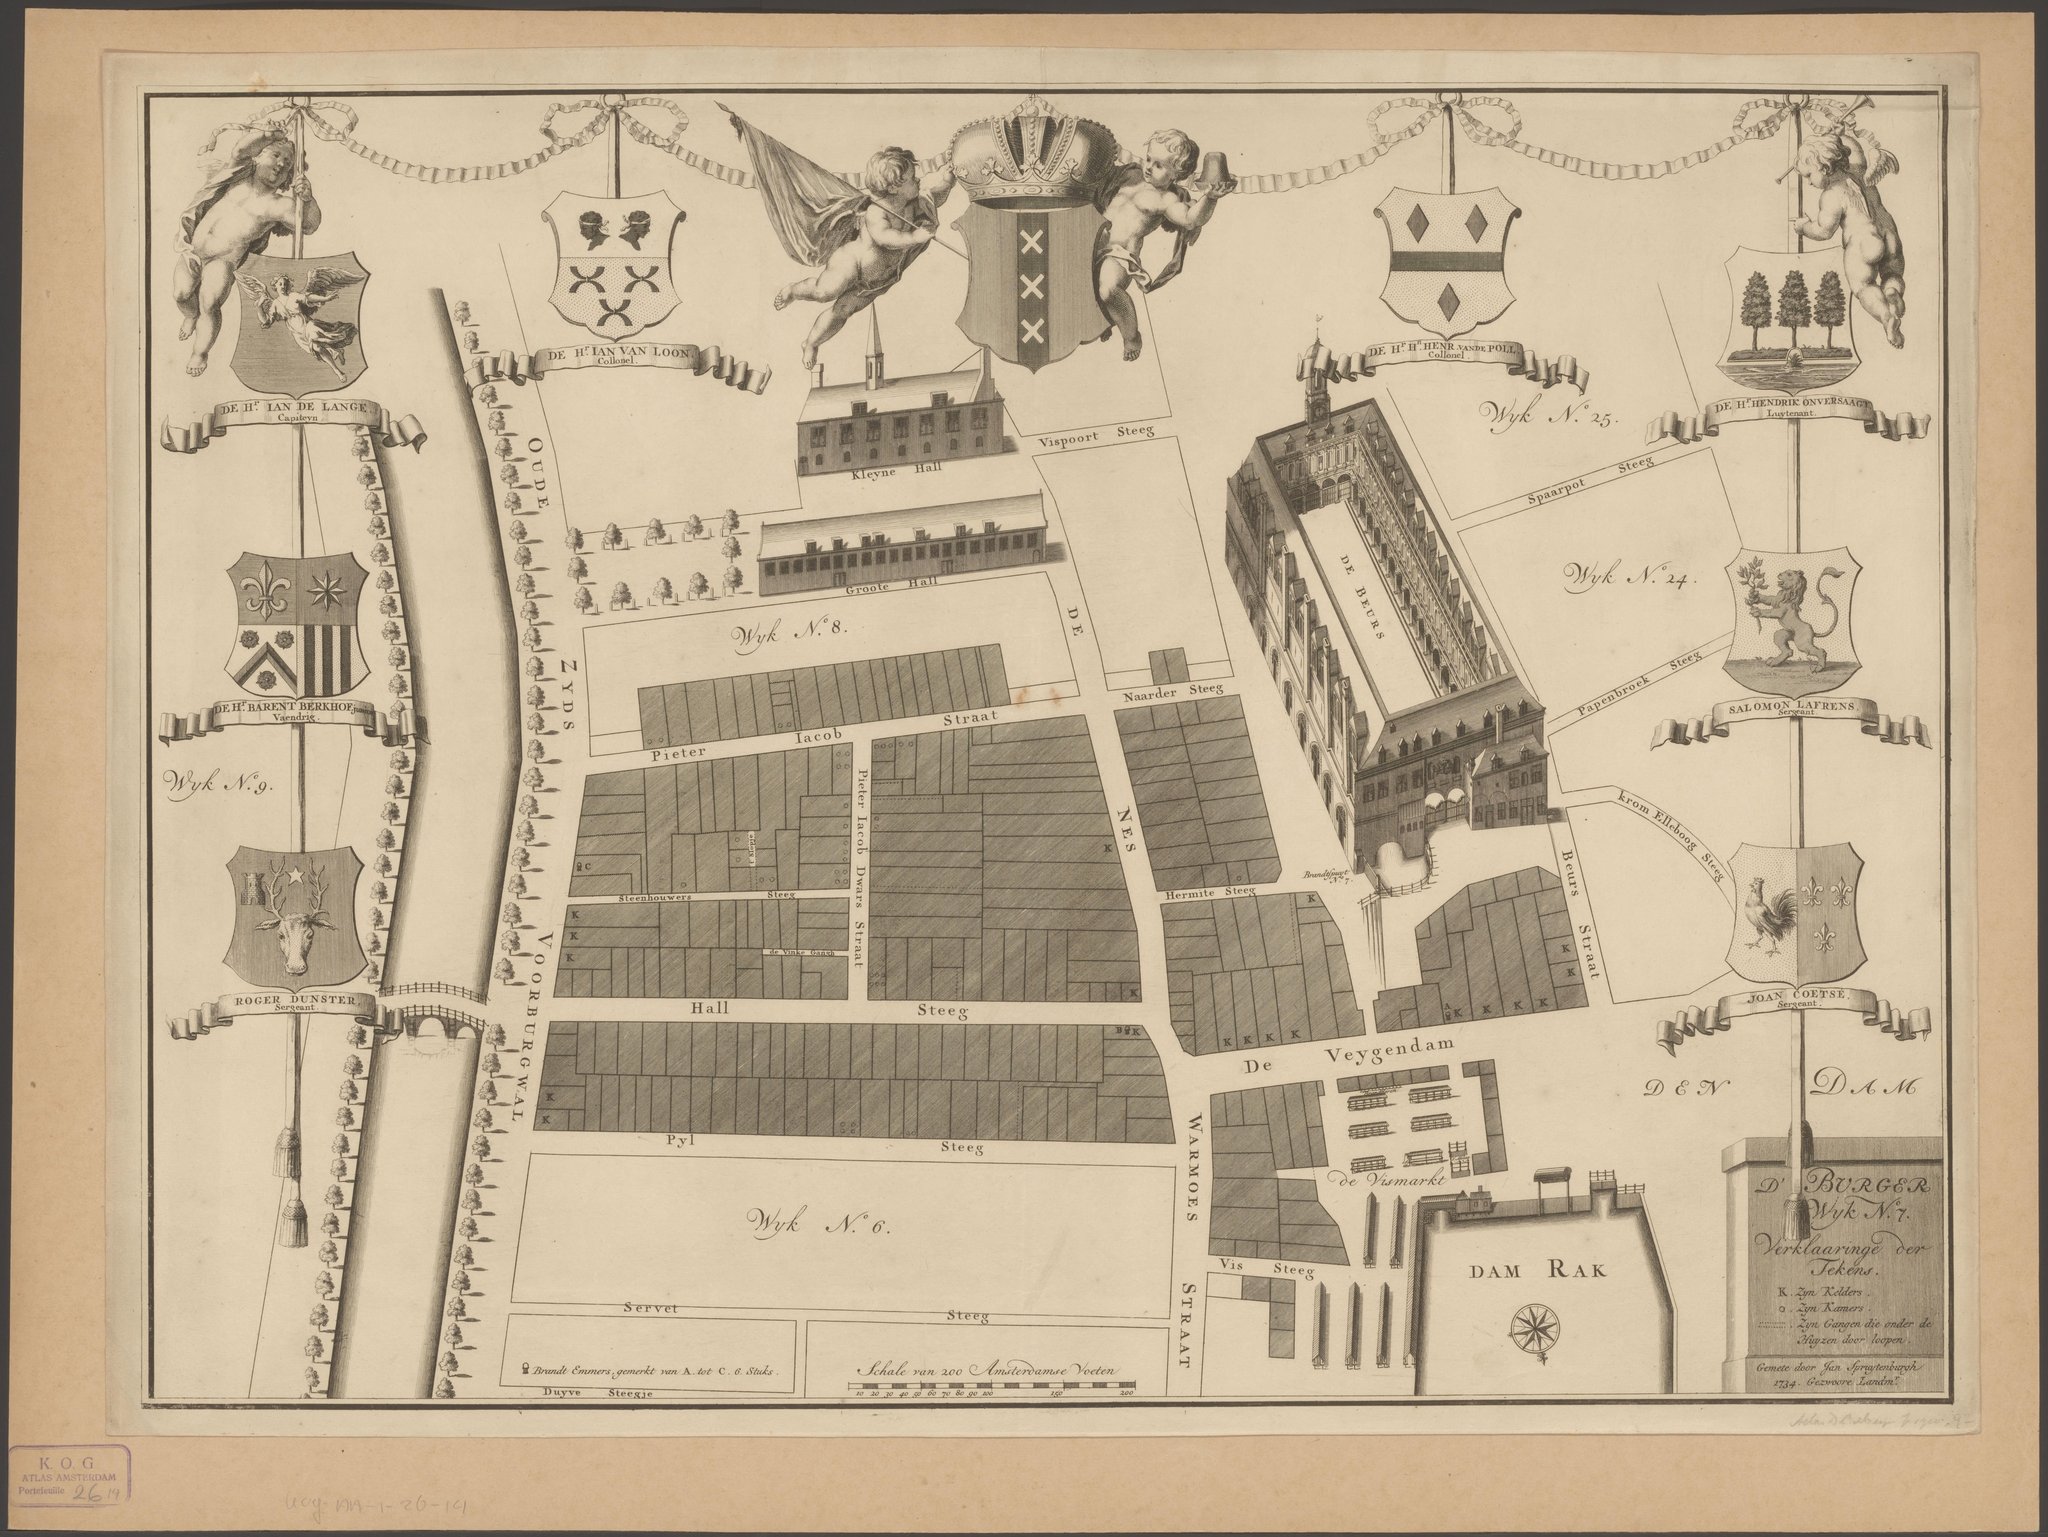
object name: area plan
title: D' Burger Wyk No. 7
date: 1734-1738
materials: paper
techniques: engraving, etching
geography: northern netherlands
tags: coat of arms (as symbol of the state, etc.) (+ city; municipal), maps of cities, armorial bearing, heraldry, amsterdam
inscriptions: collector's mark: Lugt 1641b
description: Onderwerpsrubriek binnen de Atlas Amsterdam: Schutterswijkkaarten.